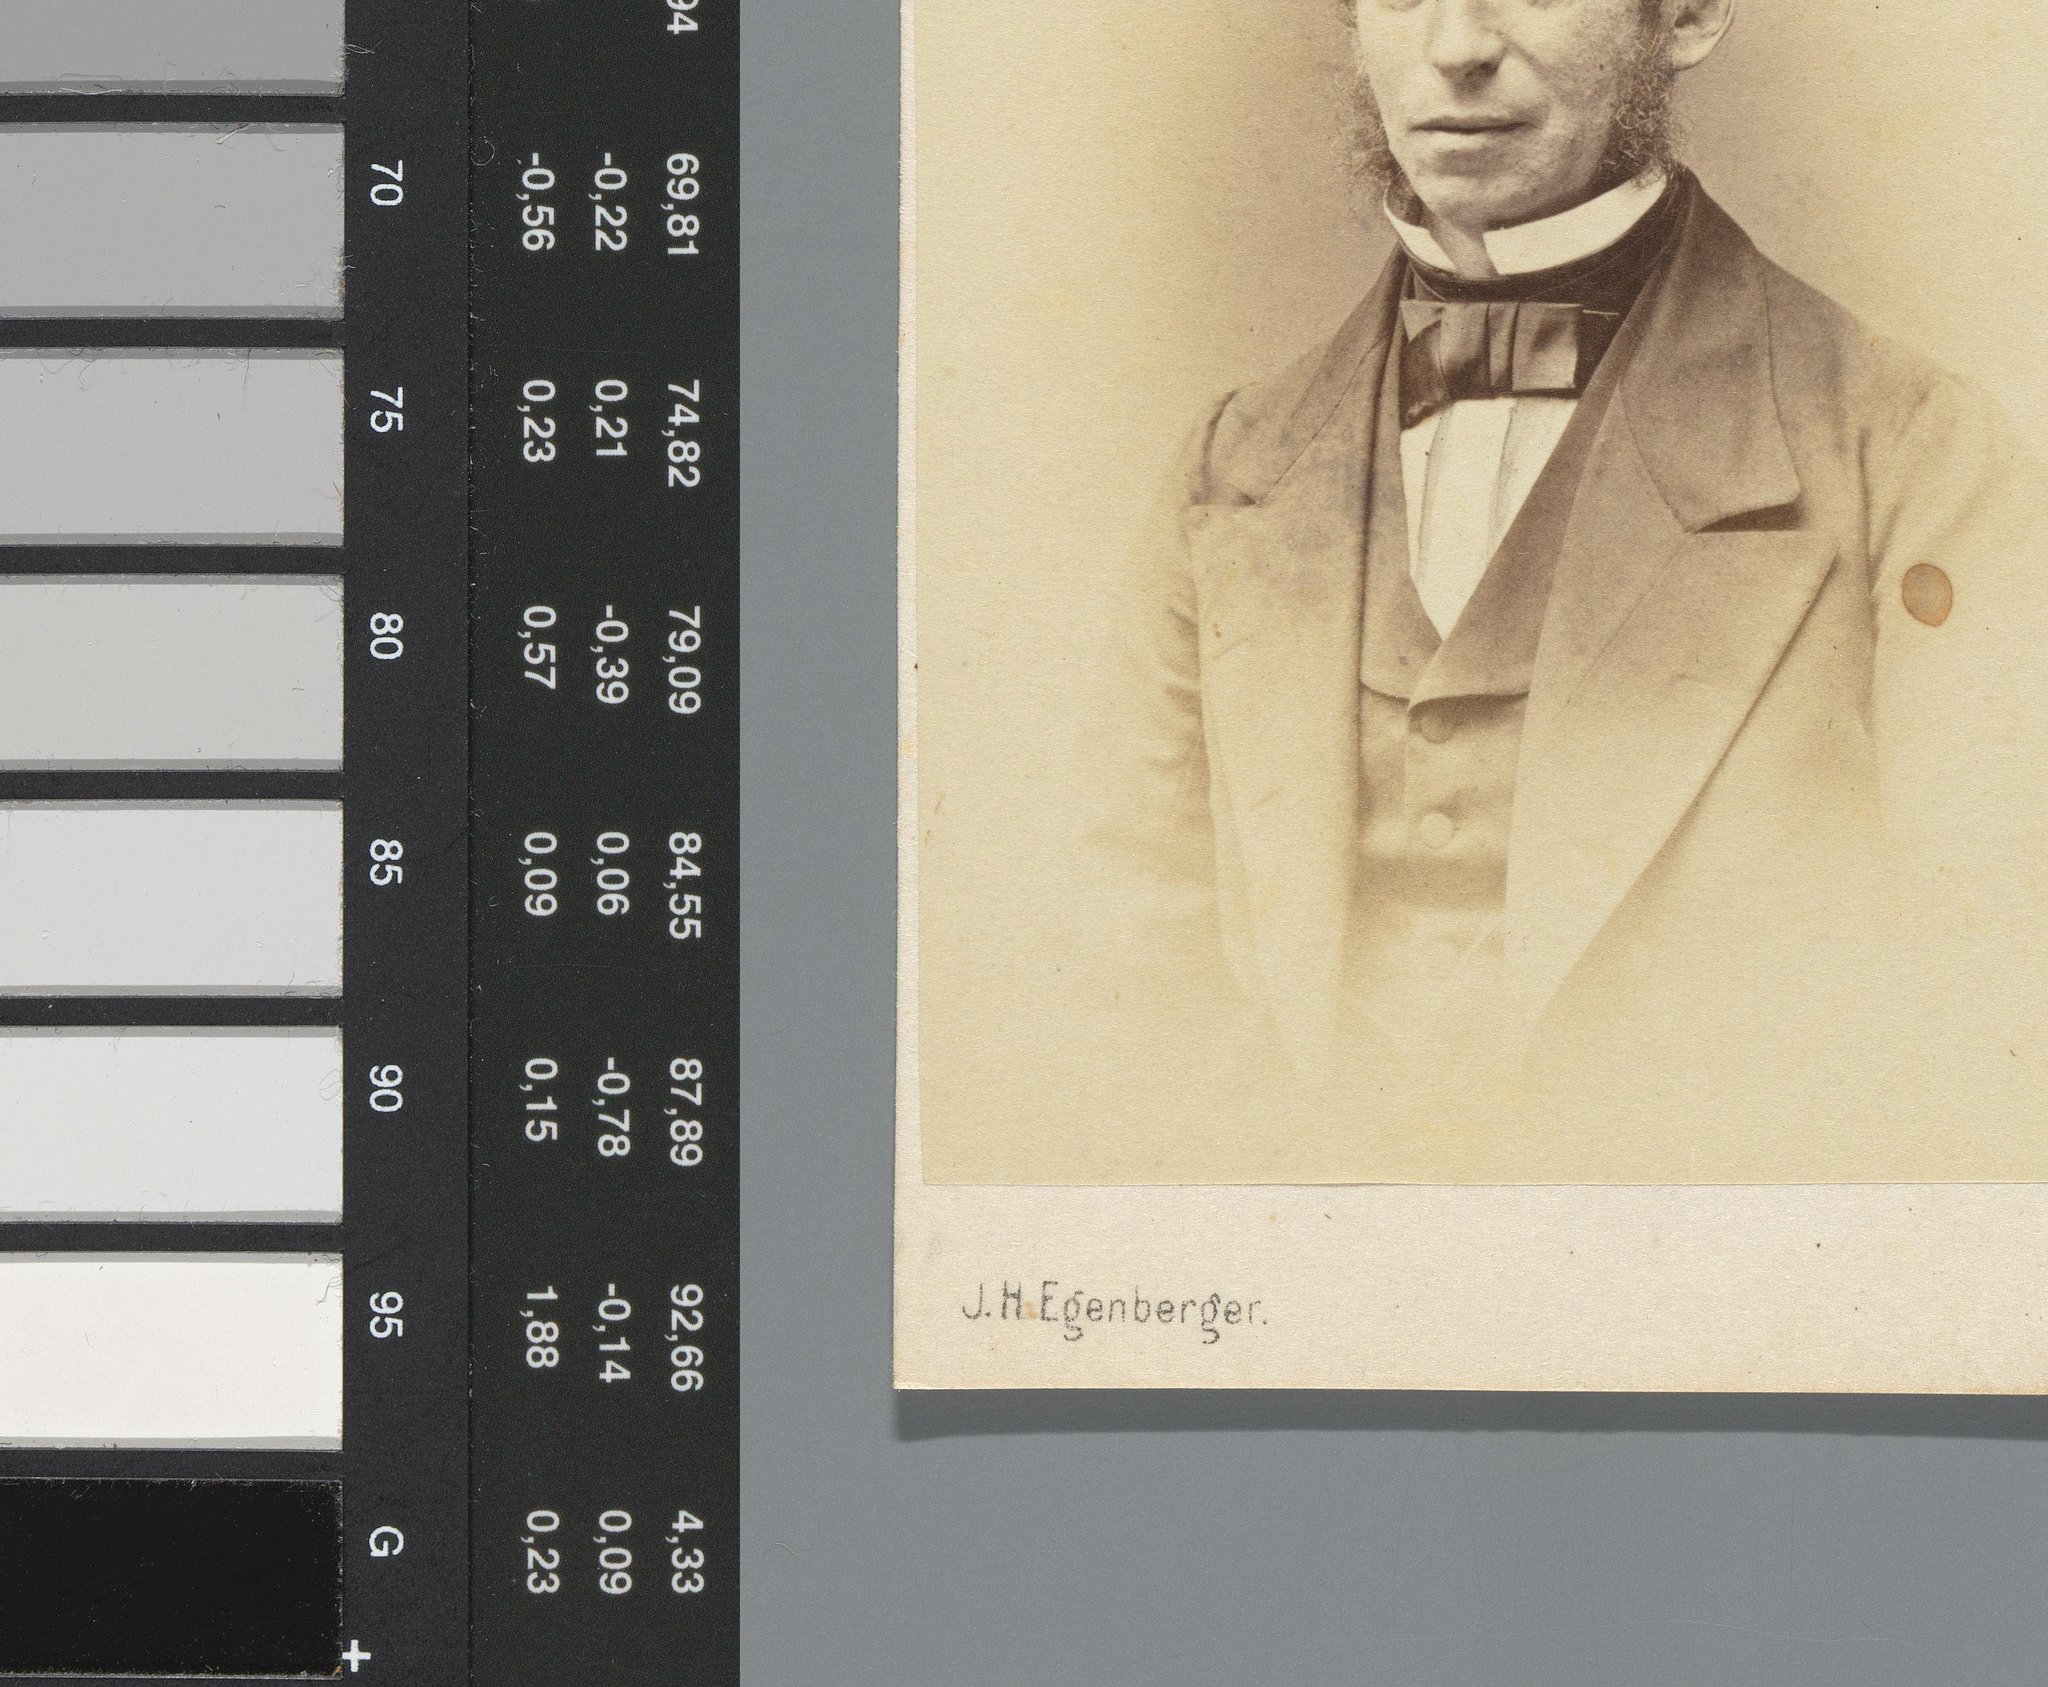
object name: photograph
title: Portret van oom Piet van Kerckhoff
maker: johannes hinderikus egenberger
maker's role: draughtsman, print maker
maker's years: 1822-1897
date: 1855-1897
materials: cardboard, photographic support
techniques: albumen print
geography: groningen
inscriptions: name: ‘J.H. EGENBERGER / GRONINGEN.’, name: ‘J.H. Egenberger’